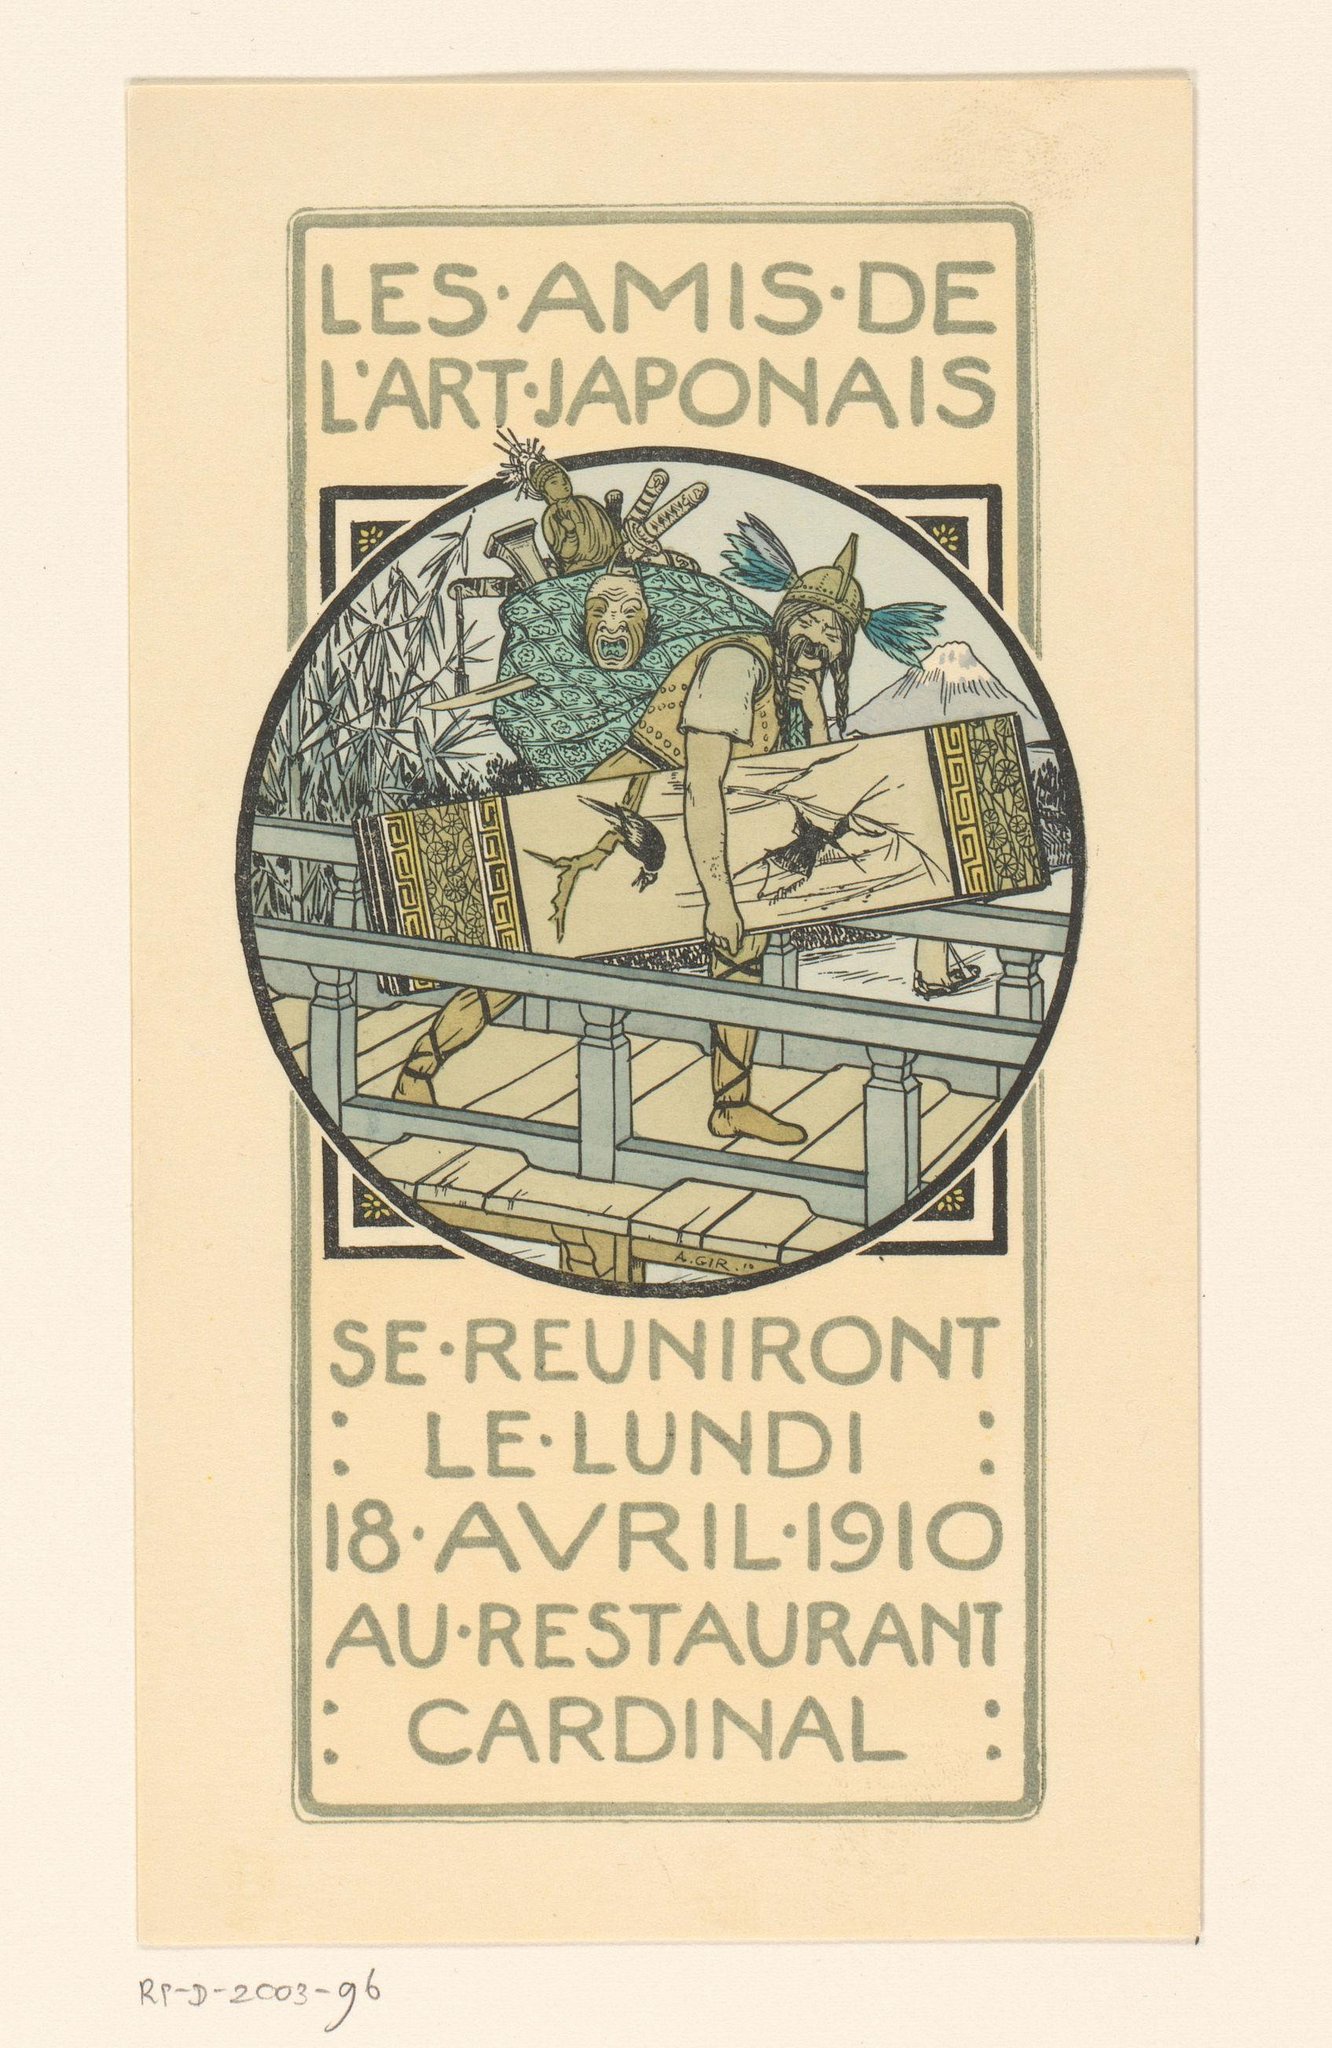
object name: invitation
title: Uitnodiging voor een diner van Les Amis de l'Art Japonais, 18 april 1910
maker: adolphe paul giraldon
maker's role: print maker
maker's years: 1855-1933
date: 1904-1910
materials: paper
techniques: wood engraving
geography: france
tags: art collector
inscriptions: collector's mark: Lugt 2228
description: Een vandaal plundert in Japan Japanse kunstvoorwerpen. Uitnodiging voor een diner van Les Amis de l'Art Japonais, 18 april 1910.